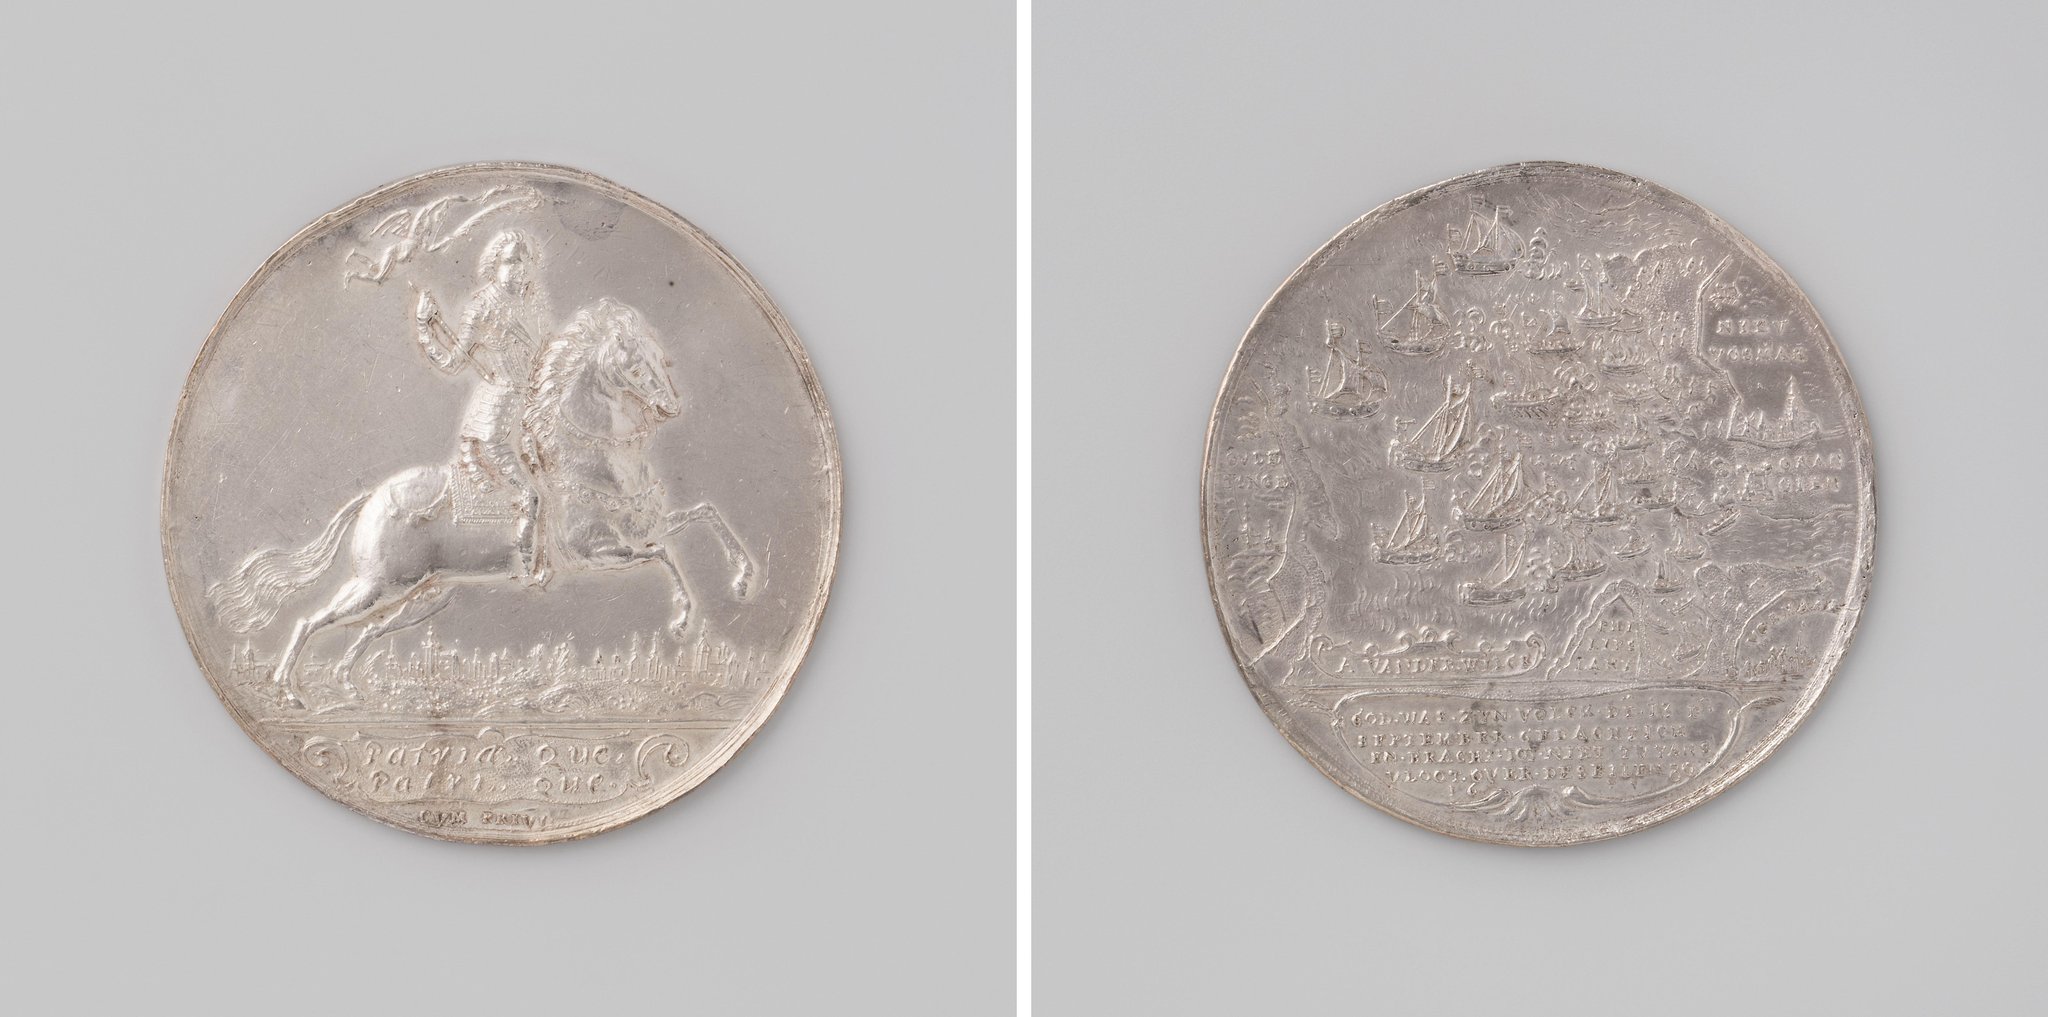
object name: history medal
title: Slag op het Slaak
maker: anthonis pietersz. van der willigen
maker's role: draughtsman, print maker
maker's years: 1591-1640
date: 1631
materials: silver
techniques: striking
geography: the hague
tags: frederick henry (prince of orange)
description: Zilveren penning. Voorzijde: portret man te paard met commandostaf, door Overwinning gekroond met lauwerkrans; op achtergrond gezicht op stad boven opschrift. Keerzijde: zeeslag boven opschrift